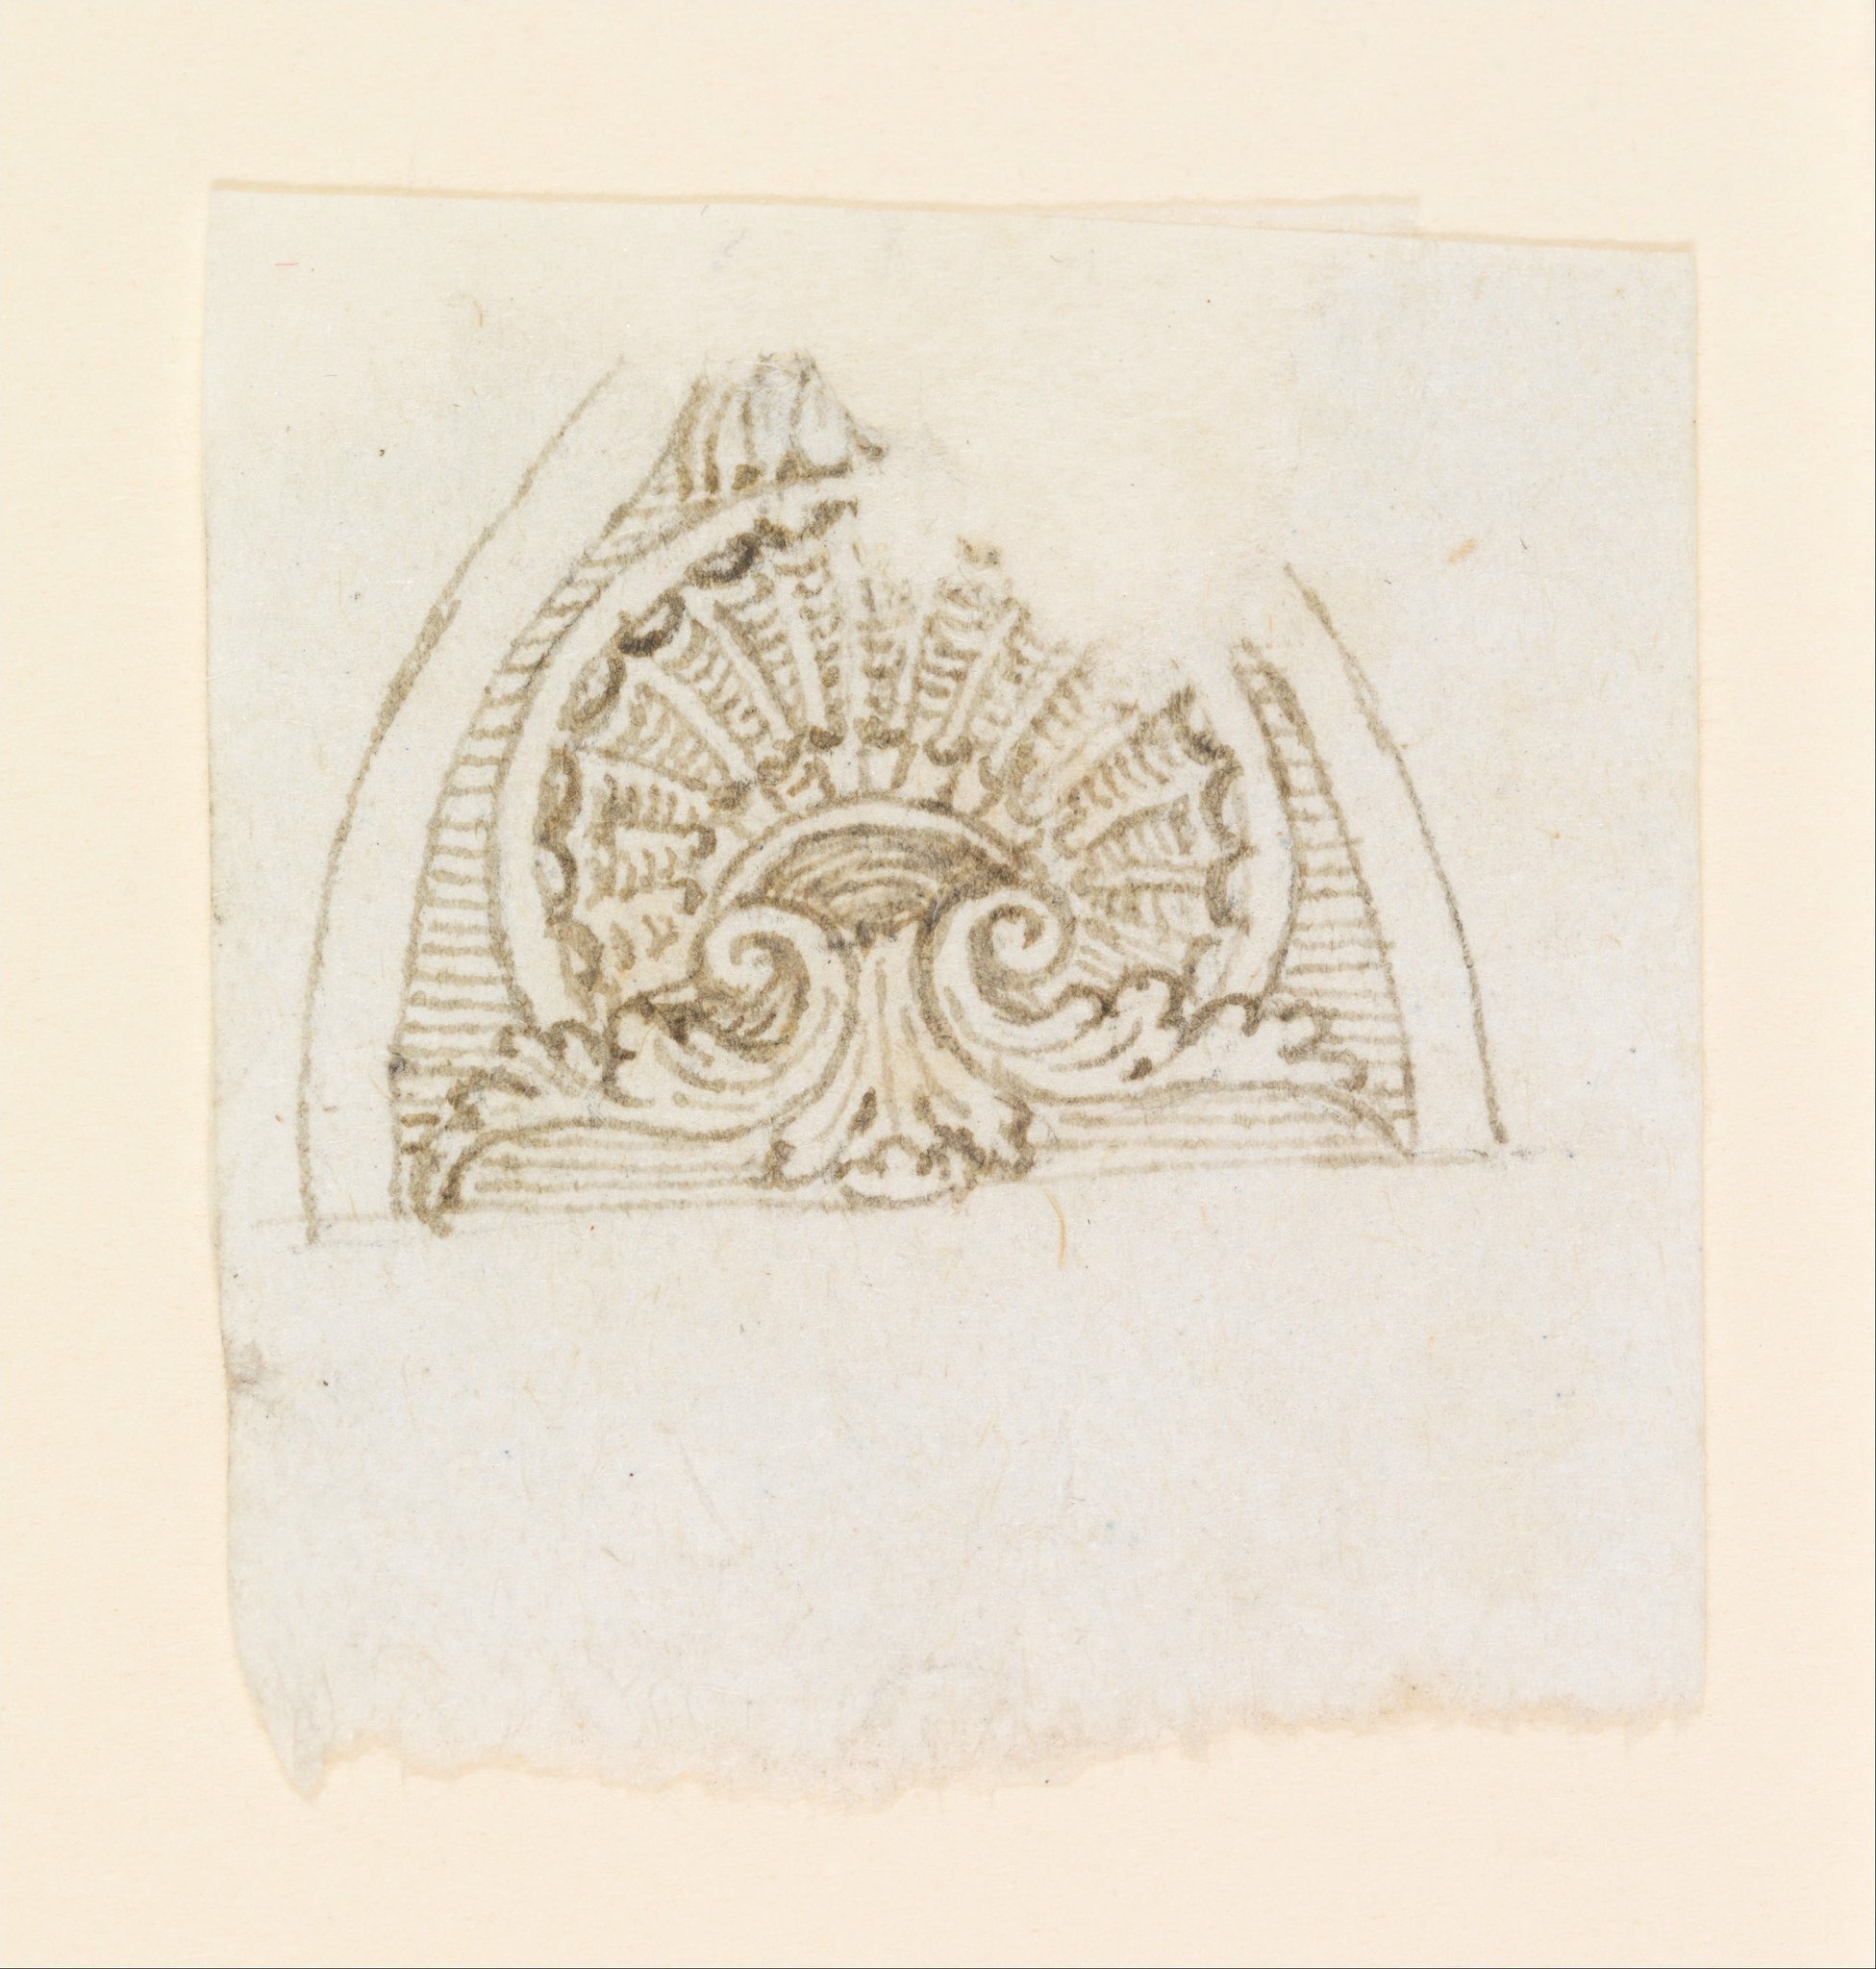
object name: drawing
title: Design for the Decoration of the Jaw of the Cock of a Firearm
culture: french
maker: nicolas noël boutet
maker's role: designer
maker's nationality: french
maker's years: 1761-1833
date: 1795-1805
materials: ink, paper, pencil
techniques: wash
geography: france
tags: ornament